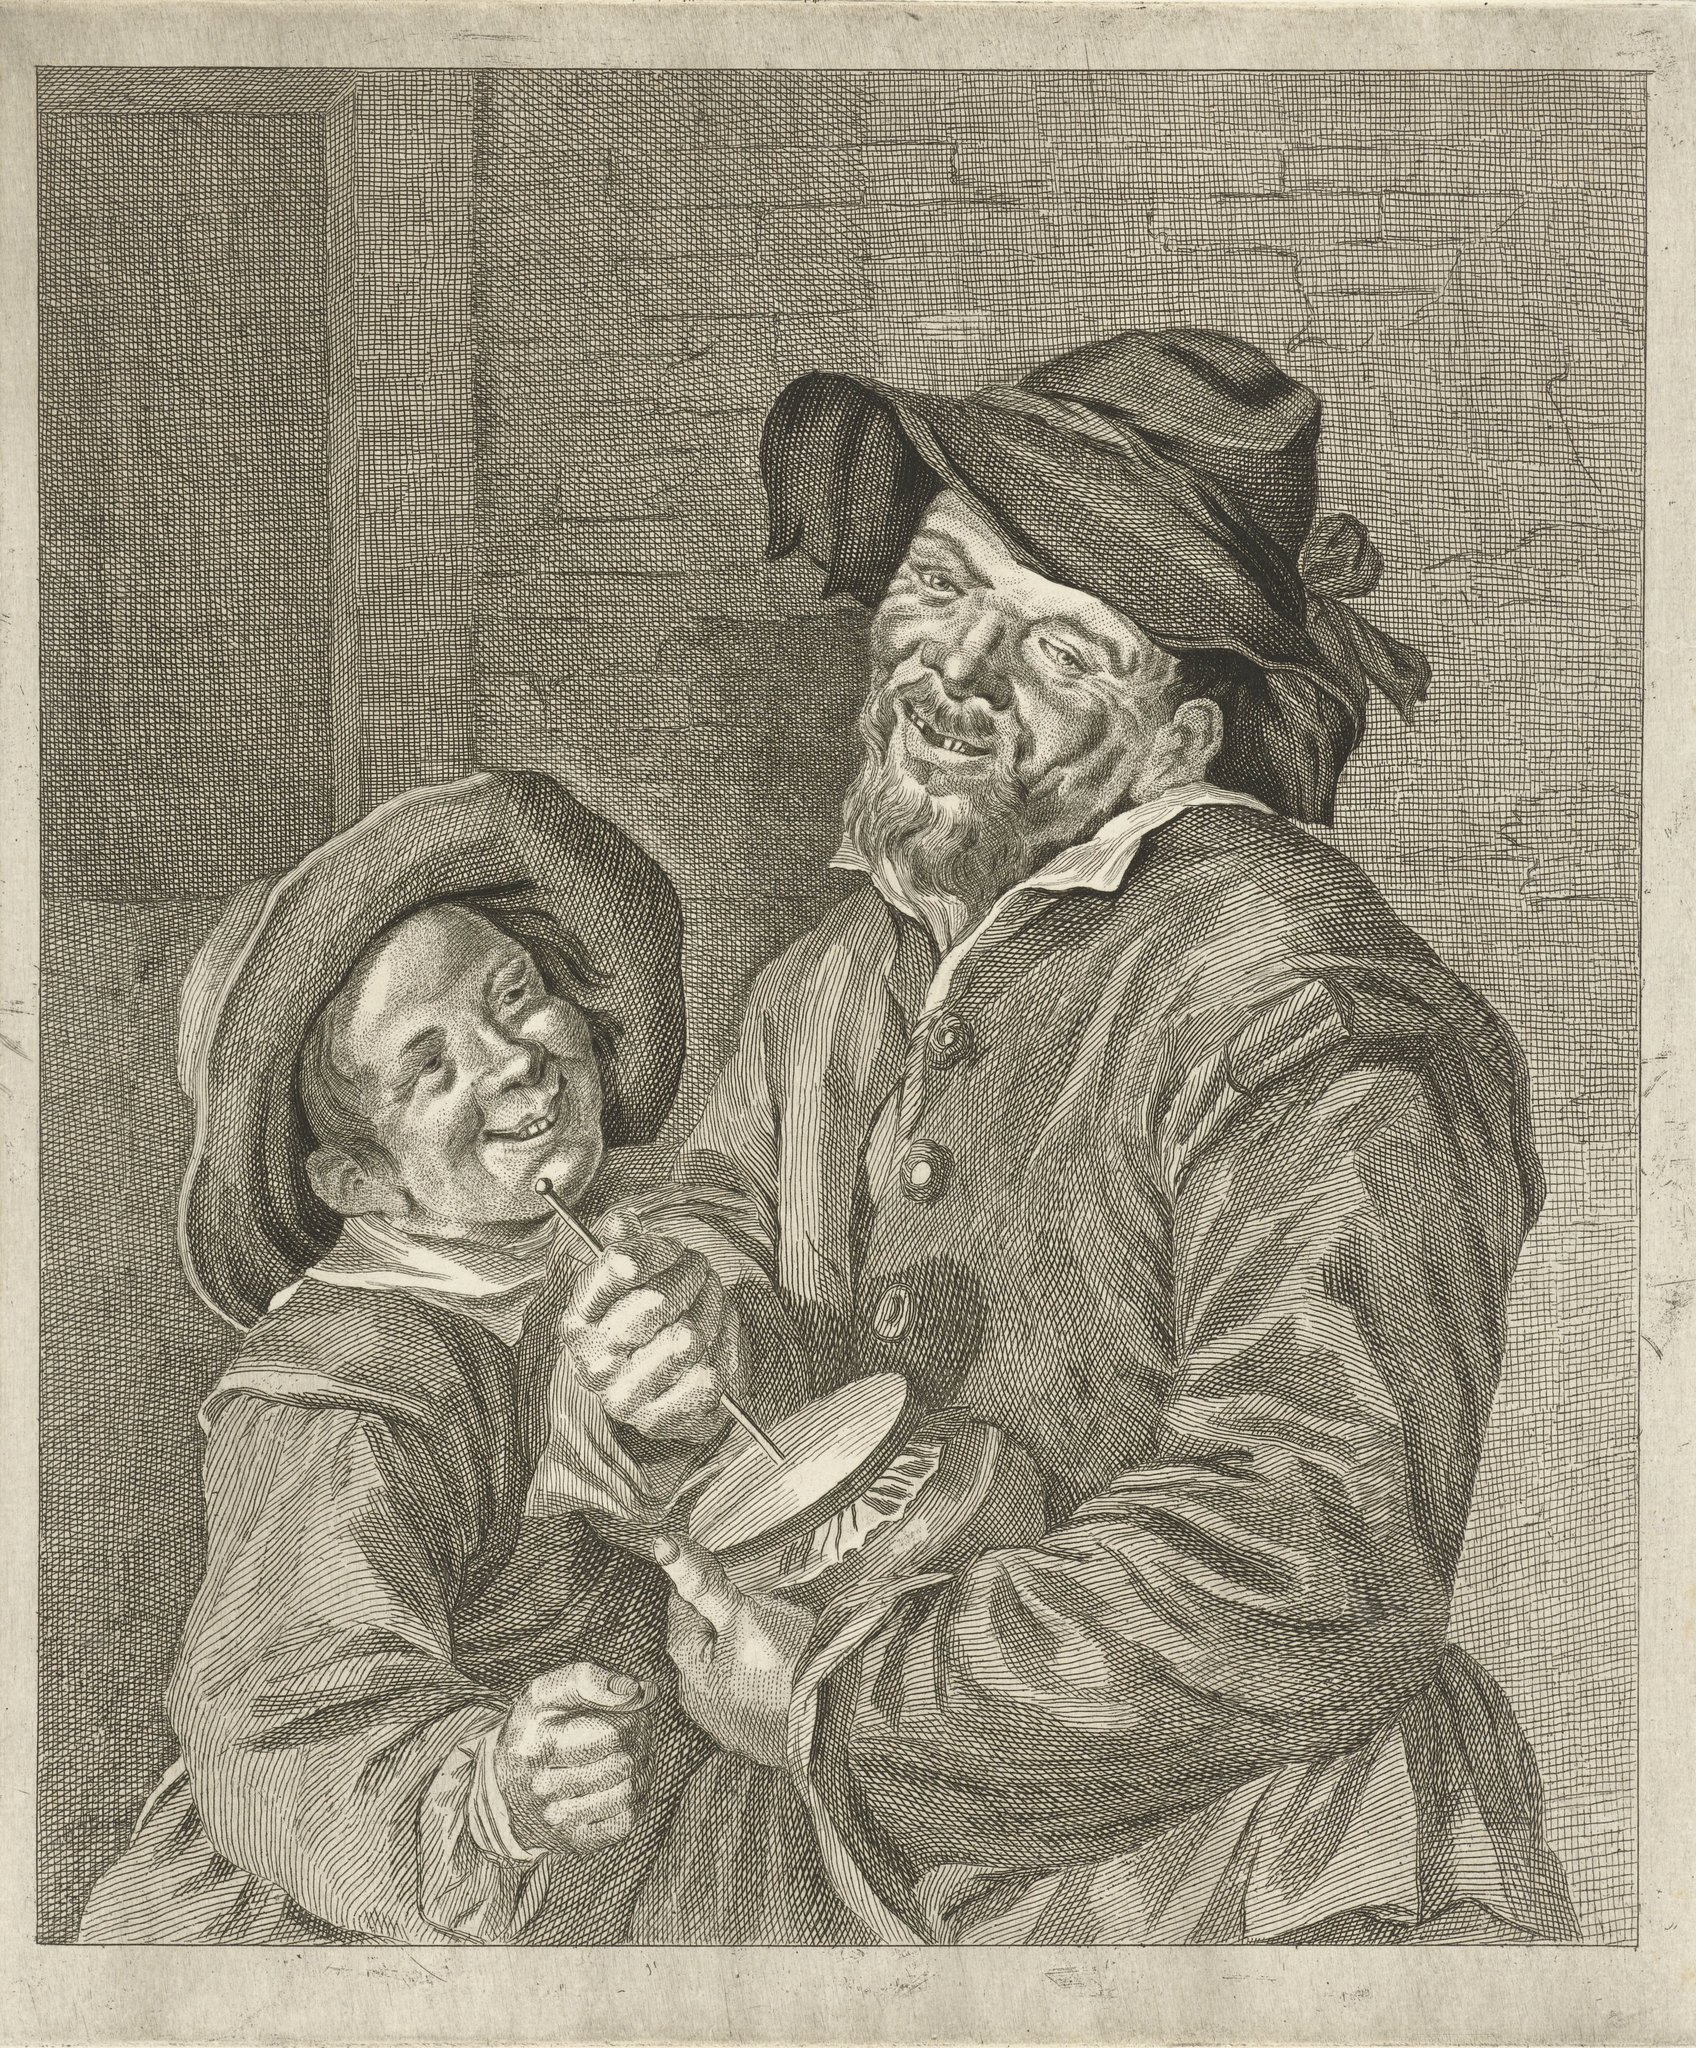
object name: print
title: De rommelpotspeler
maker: pieter de mare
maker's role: print maker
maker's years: 1758-1796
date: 1768-1796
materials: paper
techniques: engraving, etching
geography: leiden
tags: one person playing wind instrument, improvised musical instruments: rumbling pot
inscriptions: collector's mark: Lugt 240